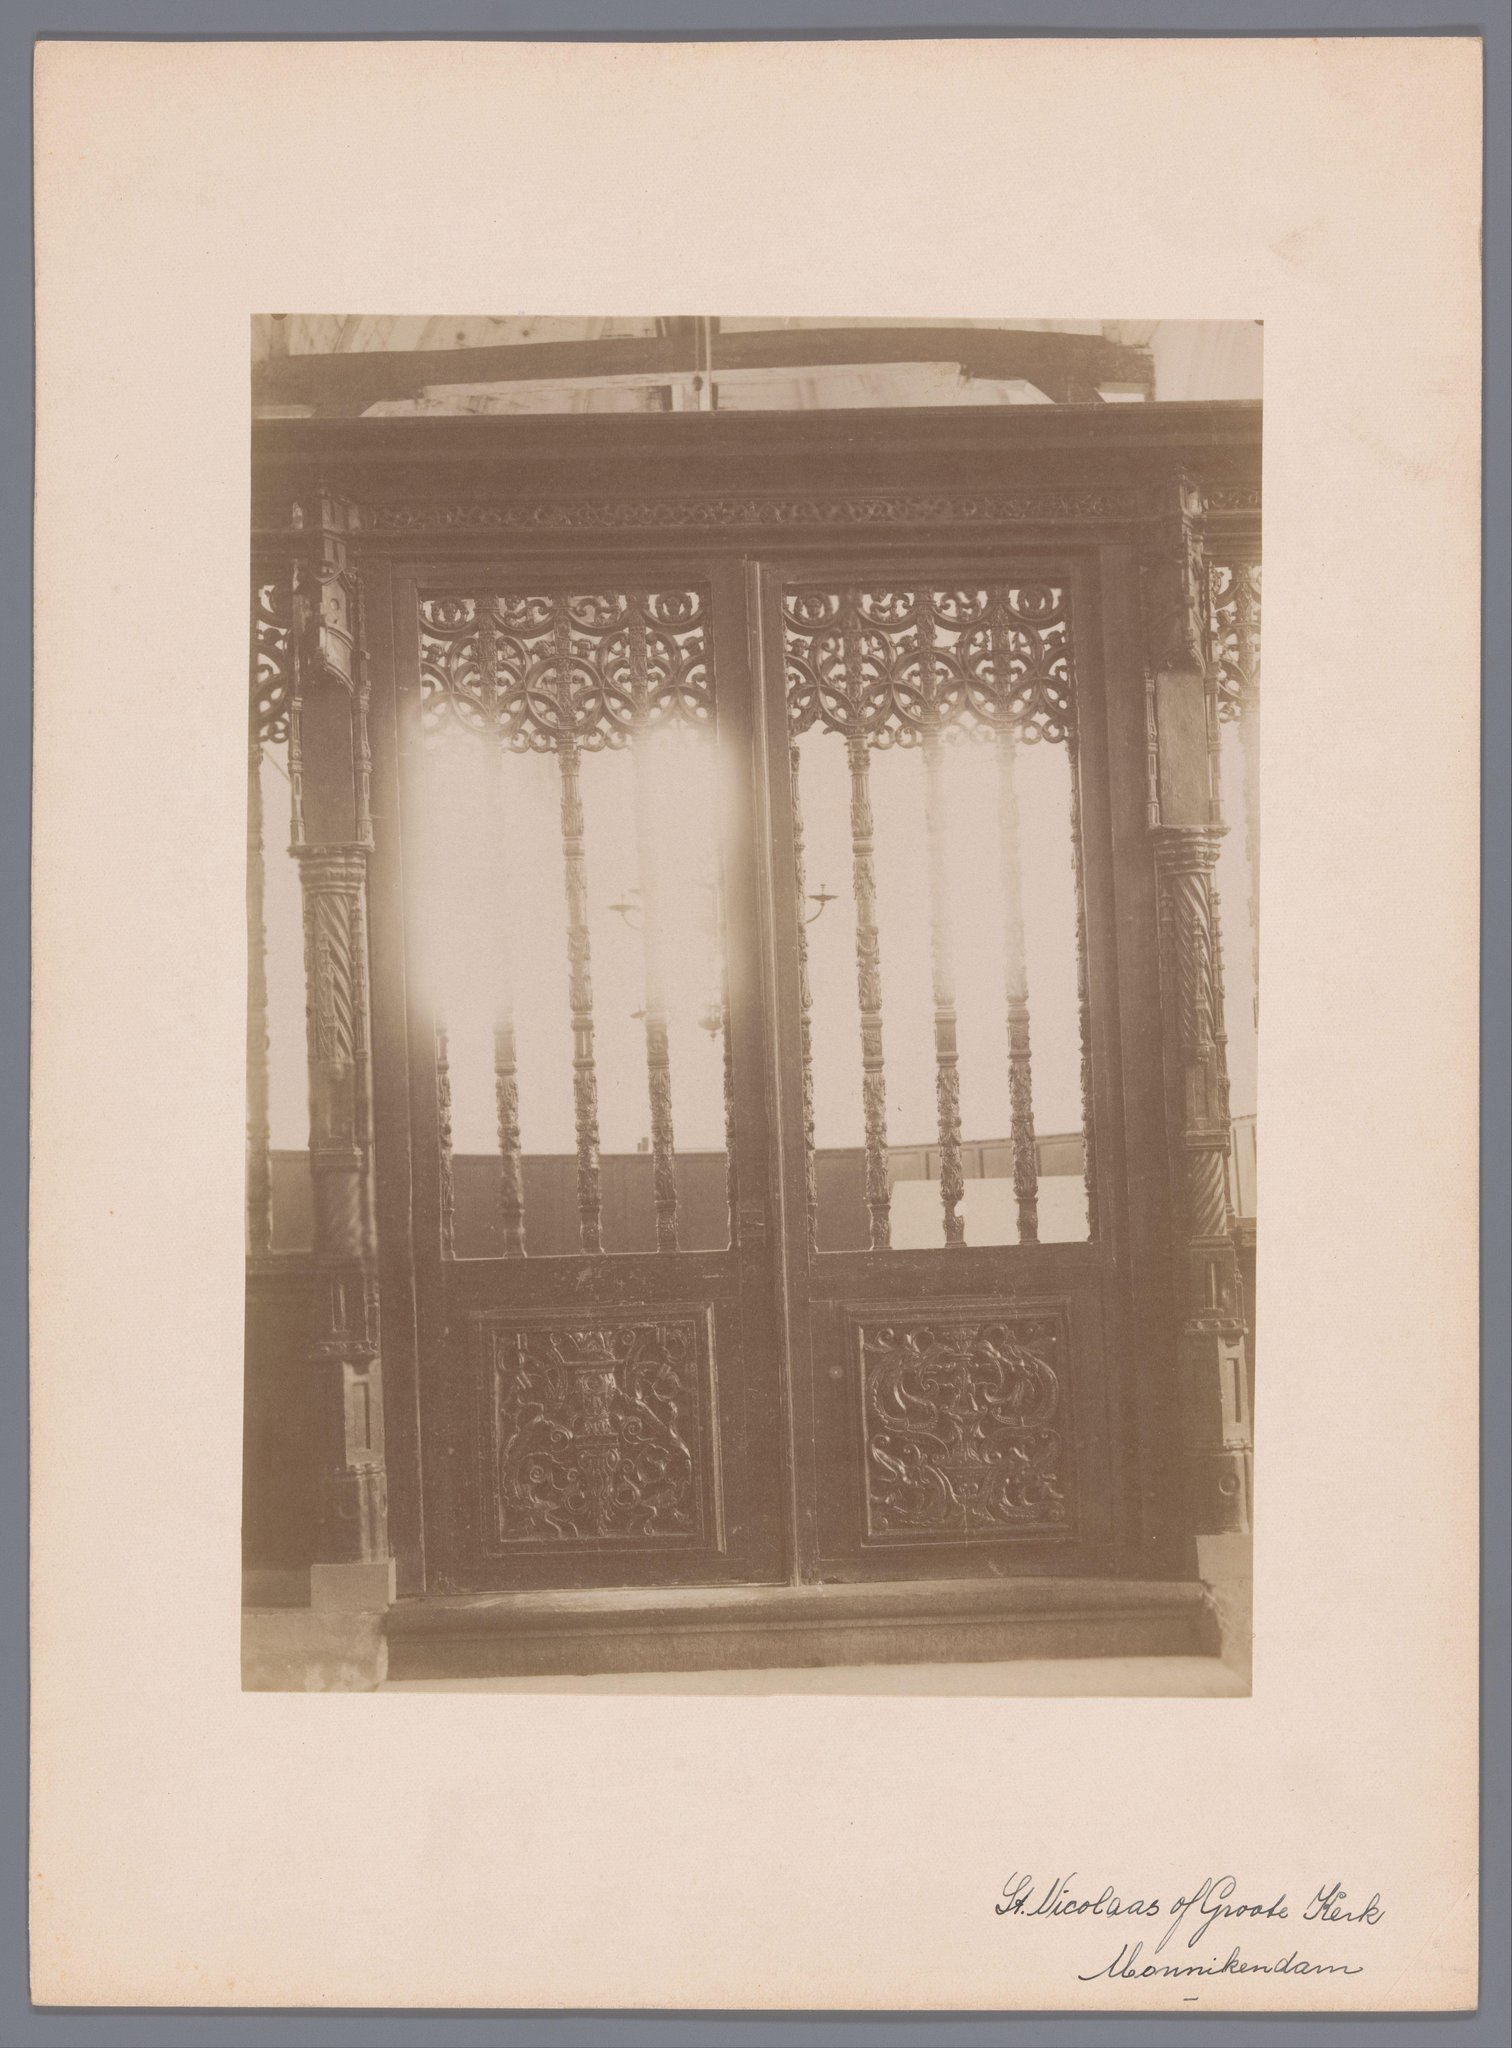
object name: photograph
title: Koorhek in de Grote of Sint-Nicolaaskerk te Monnickendam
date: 1902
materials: cardboard, photographic support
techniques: albumen print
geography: grote kerk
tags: parts of church interior, interior of church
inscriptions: annotation: ‘Monnikendam (N.H.)/ Kerk/ Koorhek 1562/ ingang/ Jan 1902’, annotation: ‘St. Nicolaas of Goote Kerk/ Monnikendam’